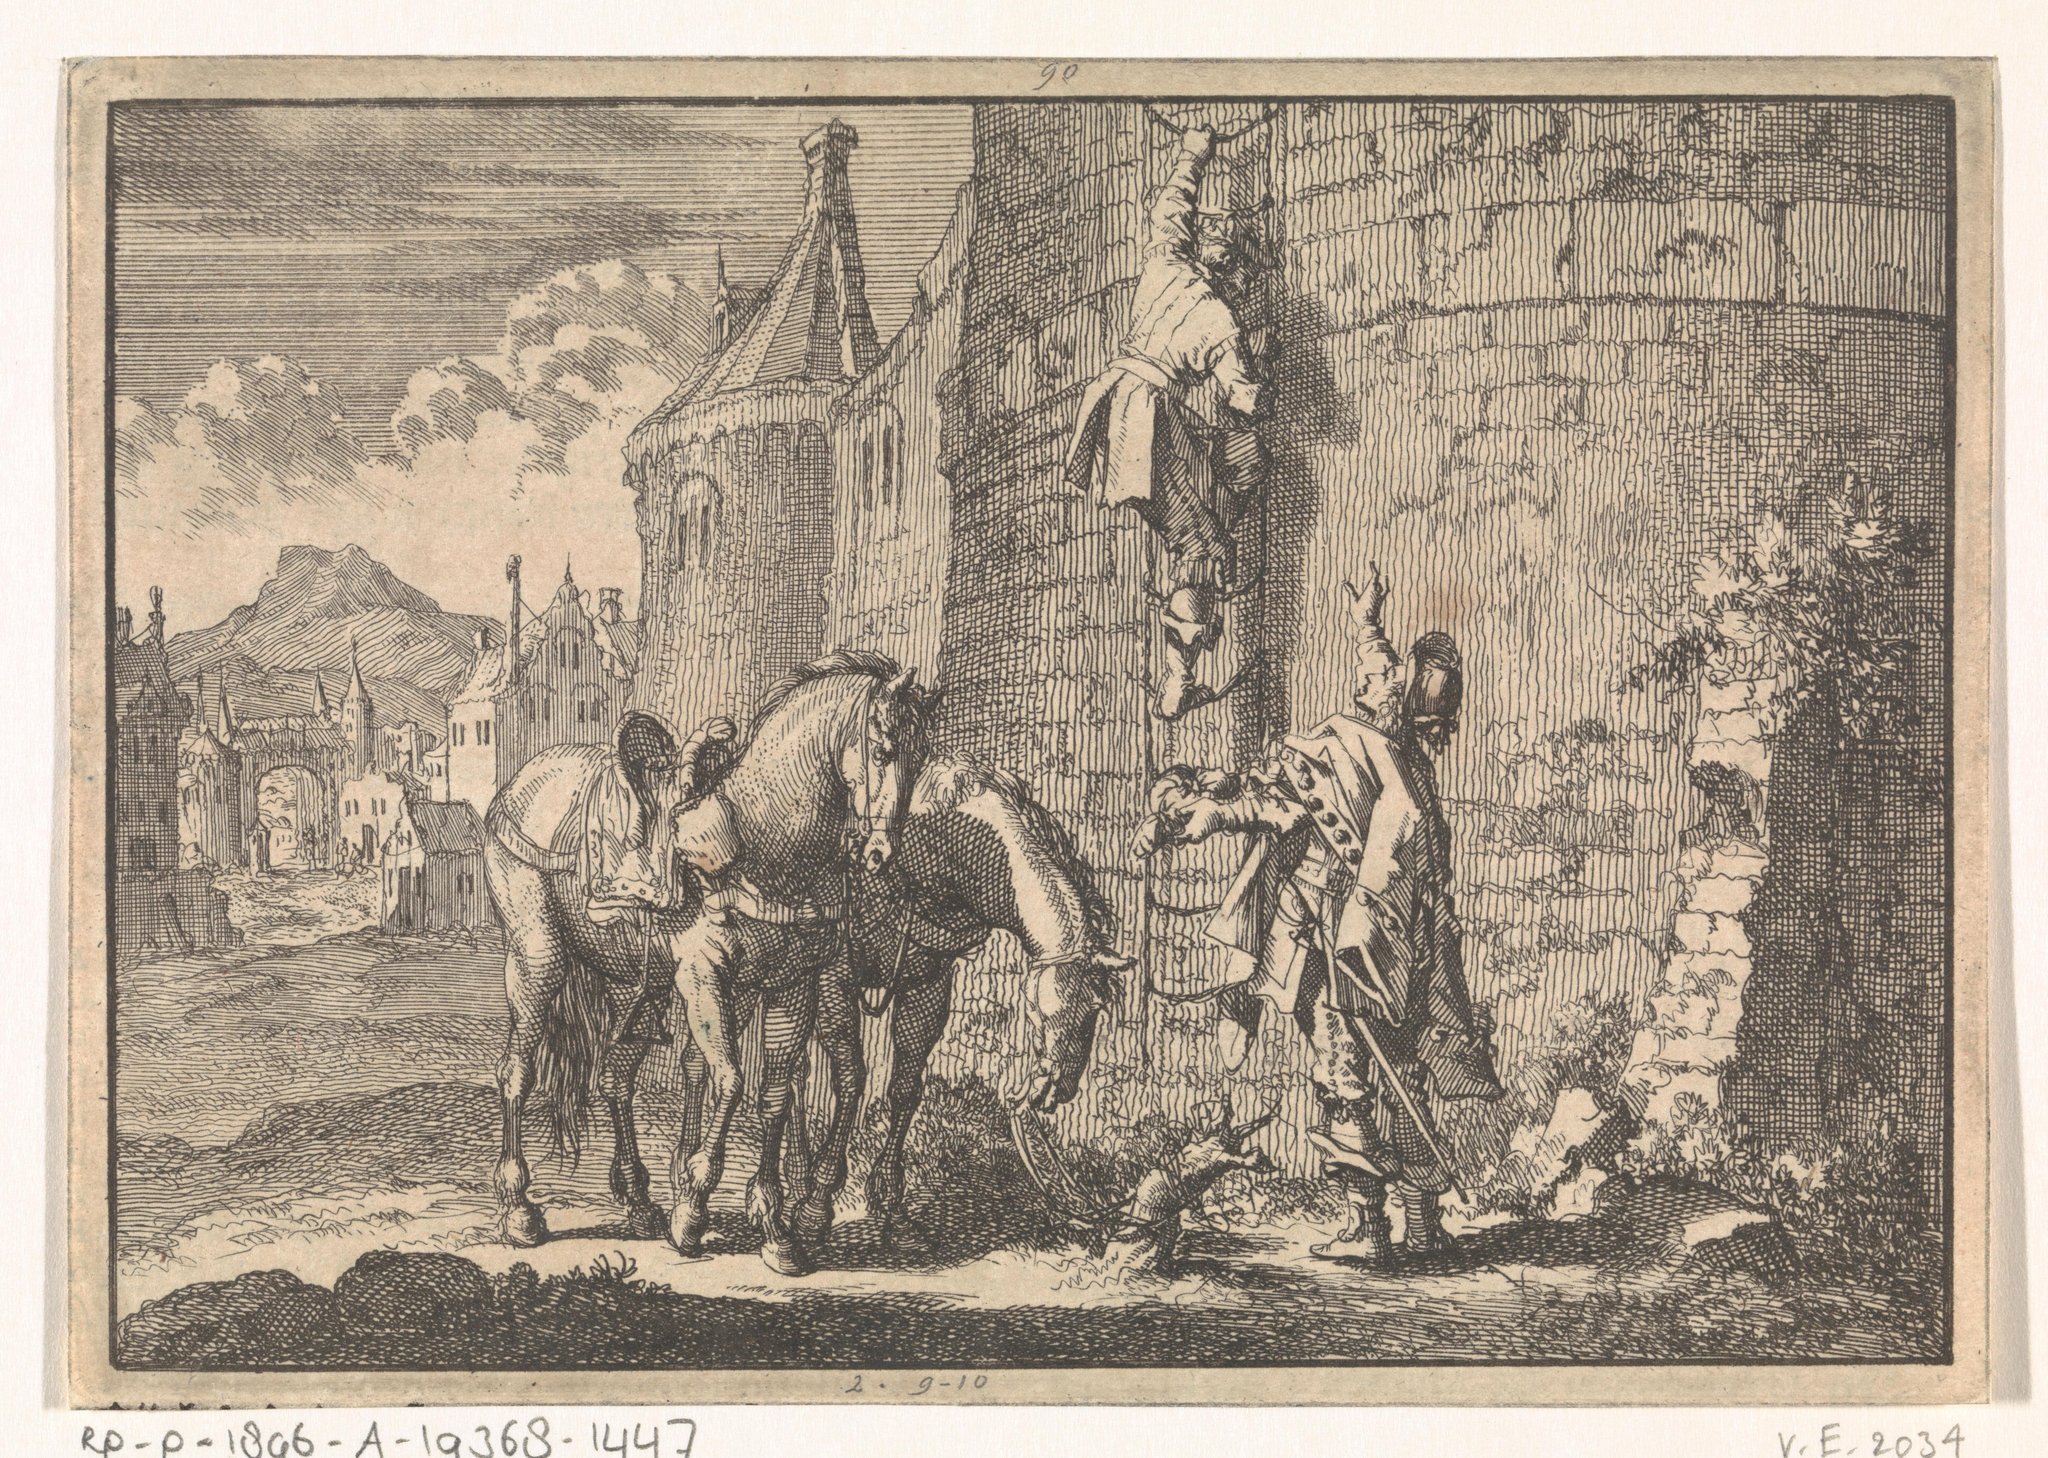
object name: book illustration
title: Hans Georg von Arnim-Boitzenburg ontsnapt met een touwladder uit de gevangenis van Stockholm, 1637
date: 1698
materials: paper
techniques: etching, letterpress printing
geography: amsterdam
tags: politician, prison, jail, escape, escape attempts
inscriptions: collector's mark: Lugt 2228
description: Illustratie uit: Gottfried, Johann Ludwig. Historische kronyck; vervattende een (...) beschrijvingh der aldergedenckwaerdigste geschiedenissen des weerelds, van den aenvangh der scheppingh tot (...) 1576 (2 delen). Leiden: Pieter van der Aa, 1698, dl. II, p. 9.